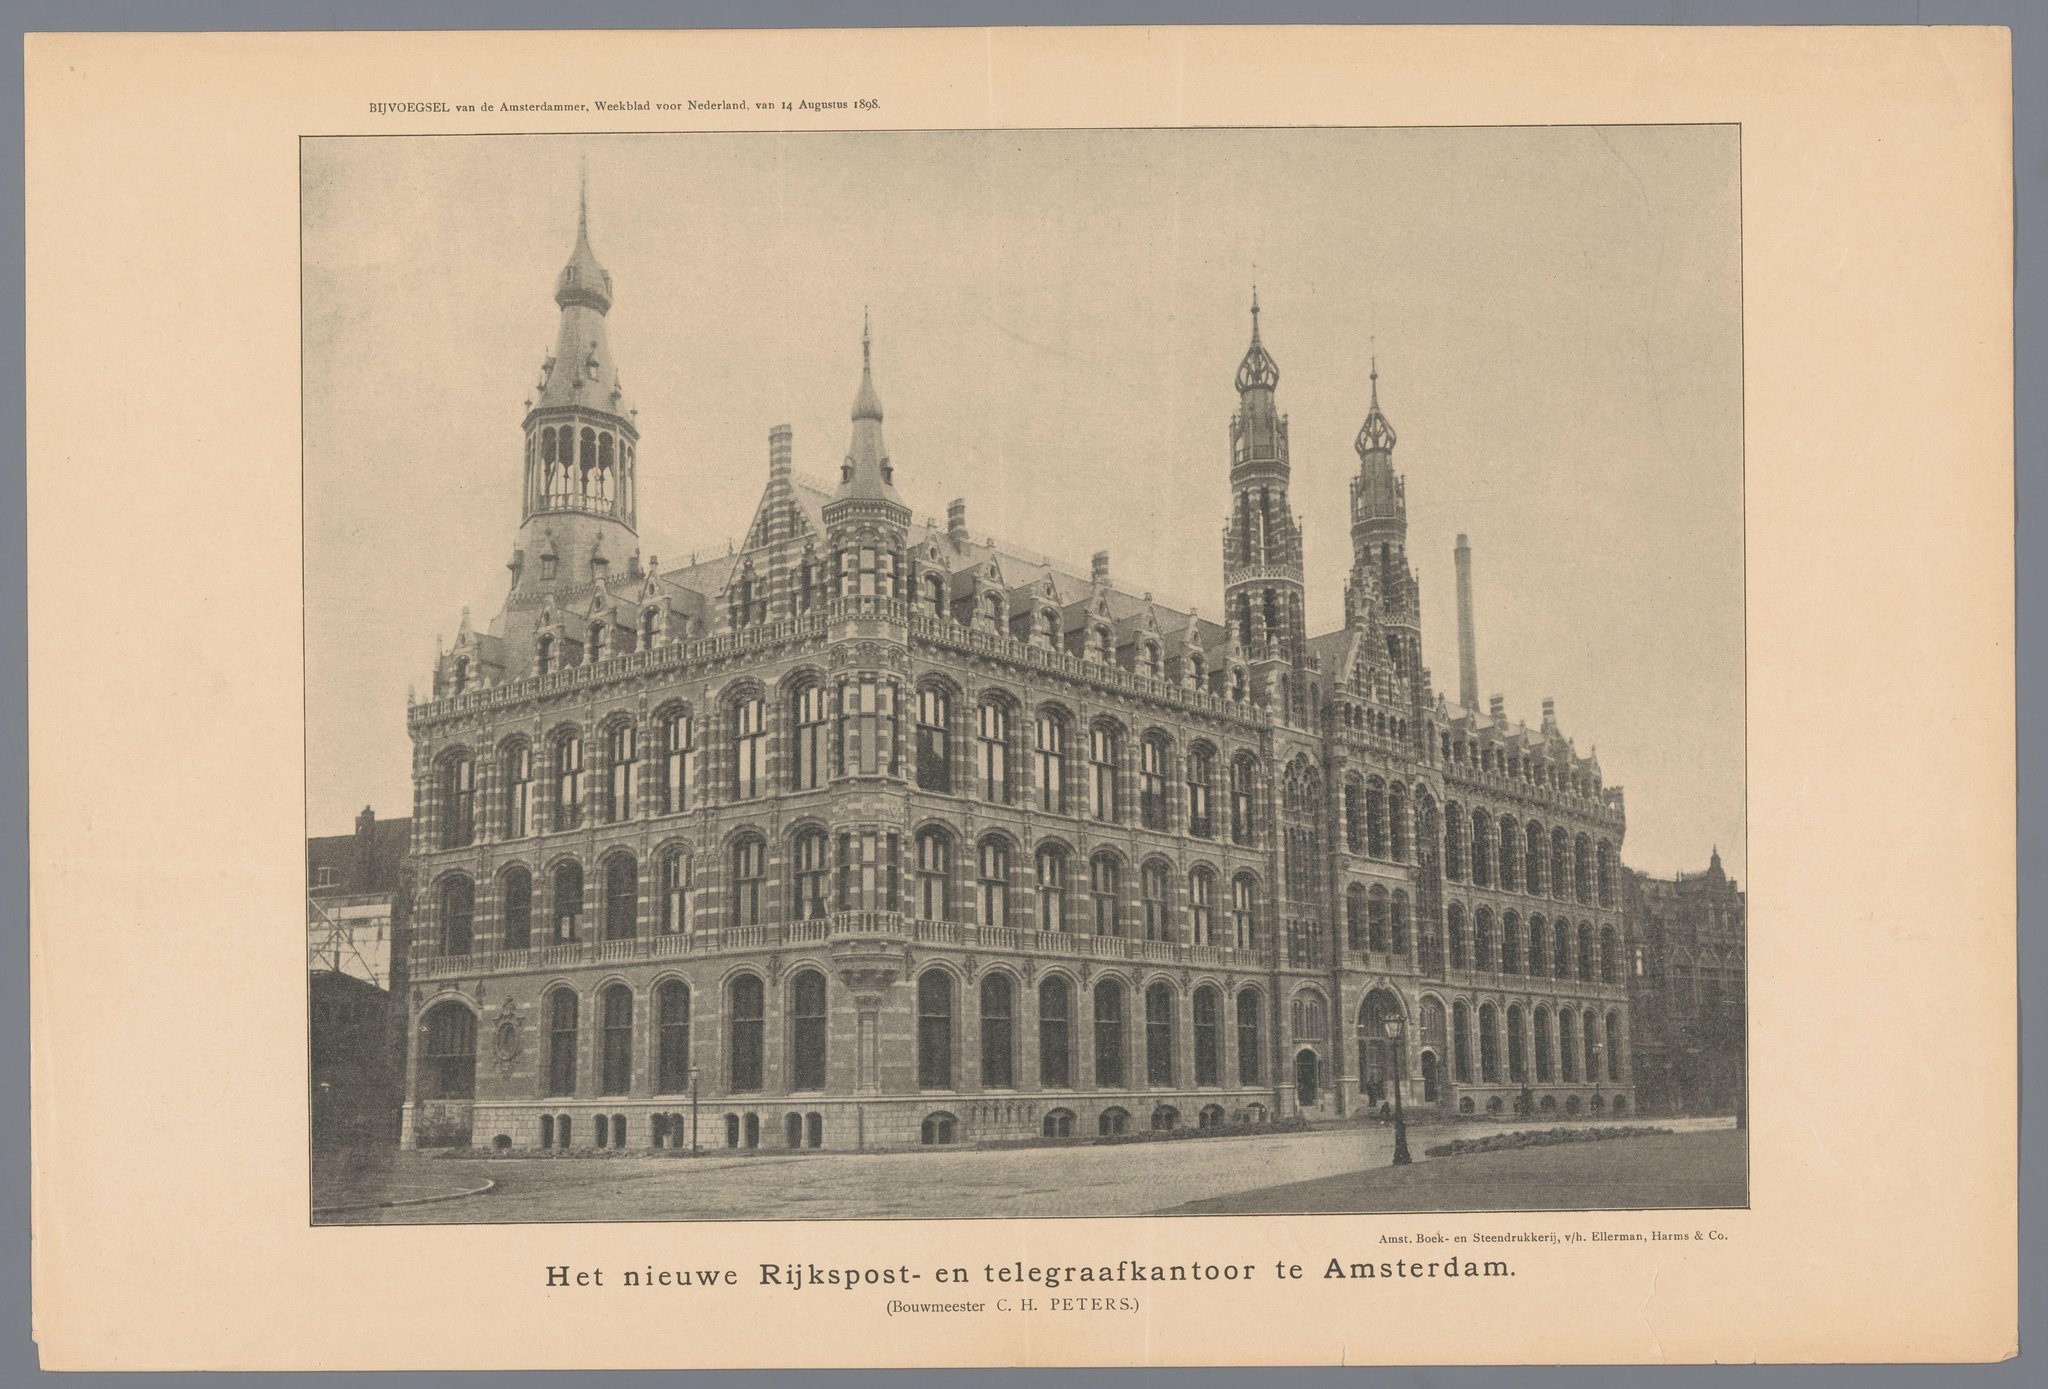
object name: photomechanical print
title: Het nieuwe Rijkspost-en telegraafkantoor te Amsterdam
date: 1898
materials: paper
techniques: autotype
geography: amsterdam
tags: exterior ~ representation of a building, civic architecture; edifices; dwellings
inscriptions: date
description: Afdruk uit: De Amsterdammer, Weekblad voor Nederland, 14 augustus 1898.